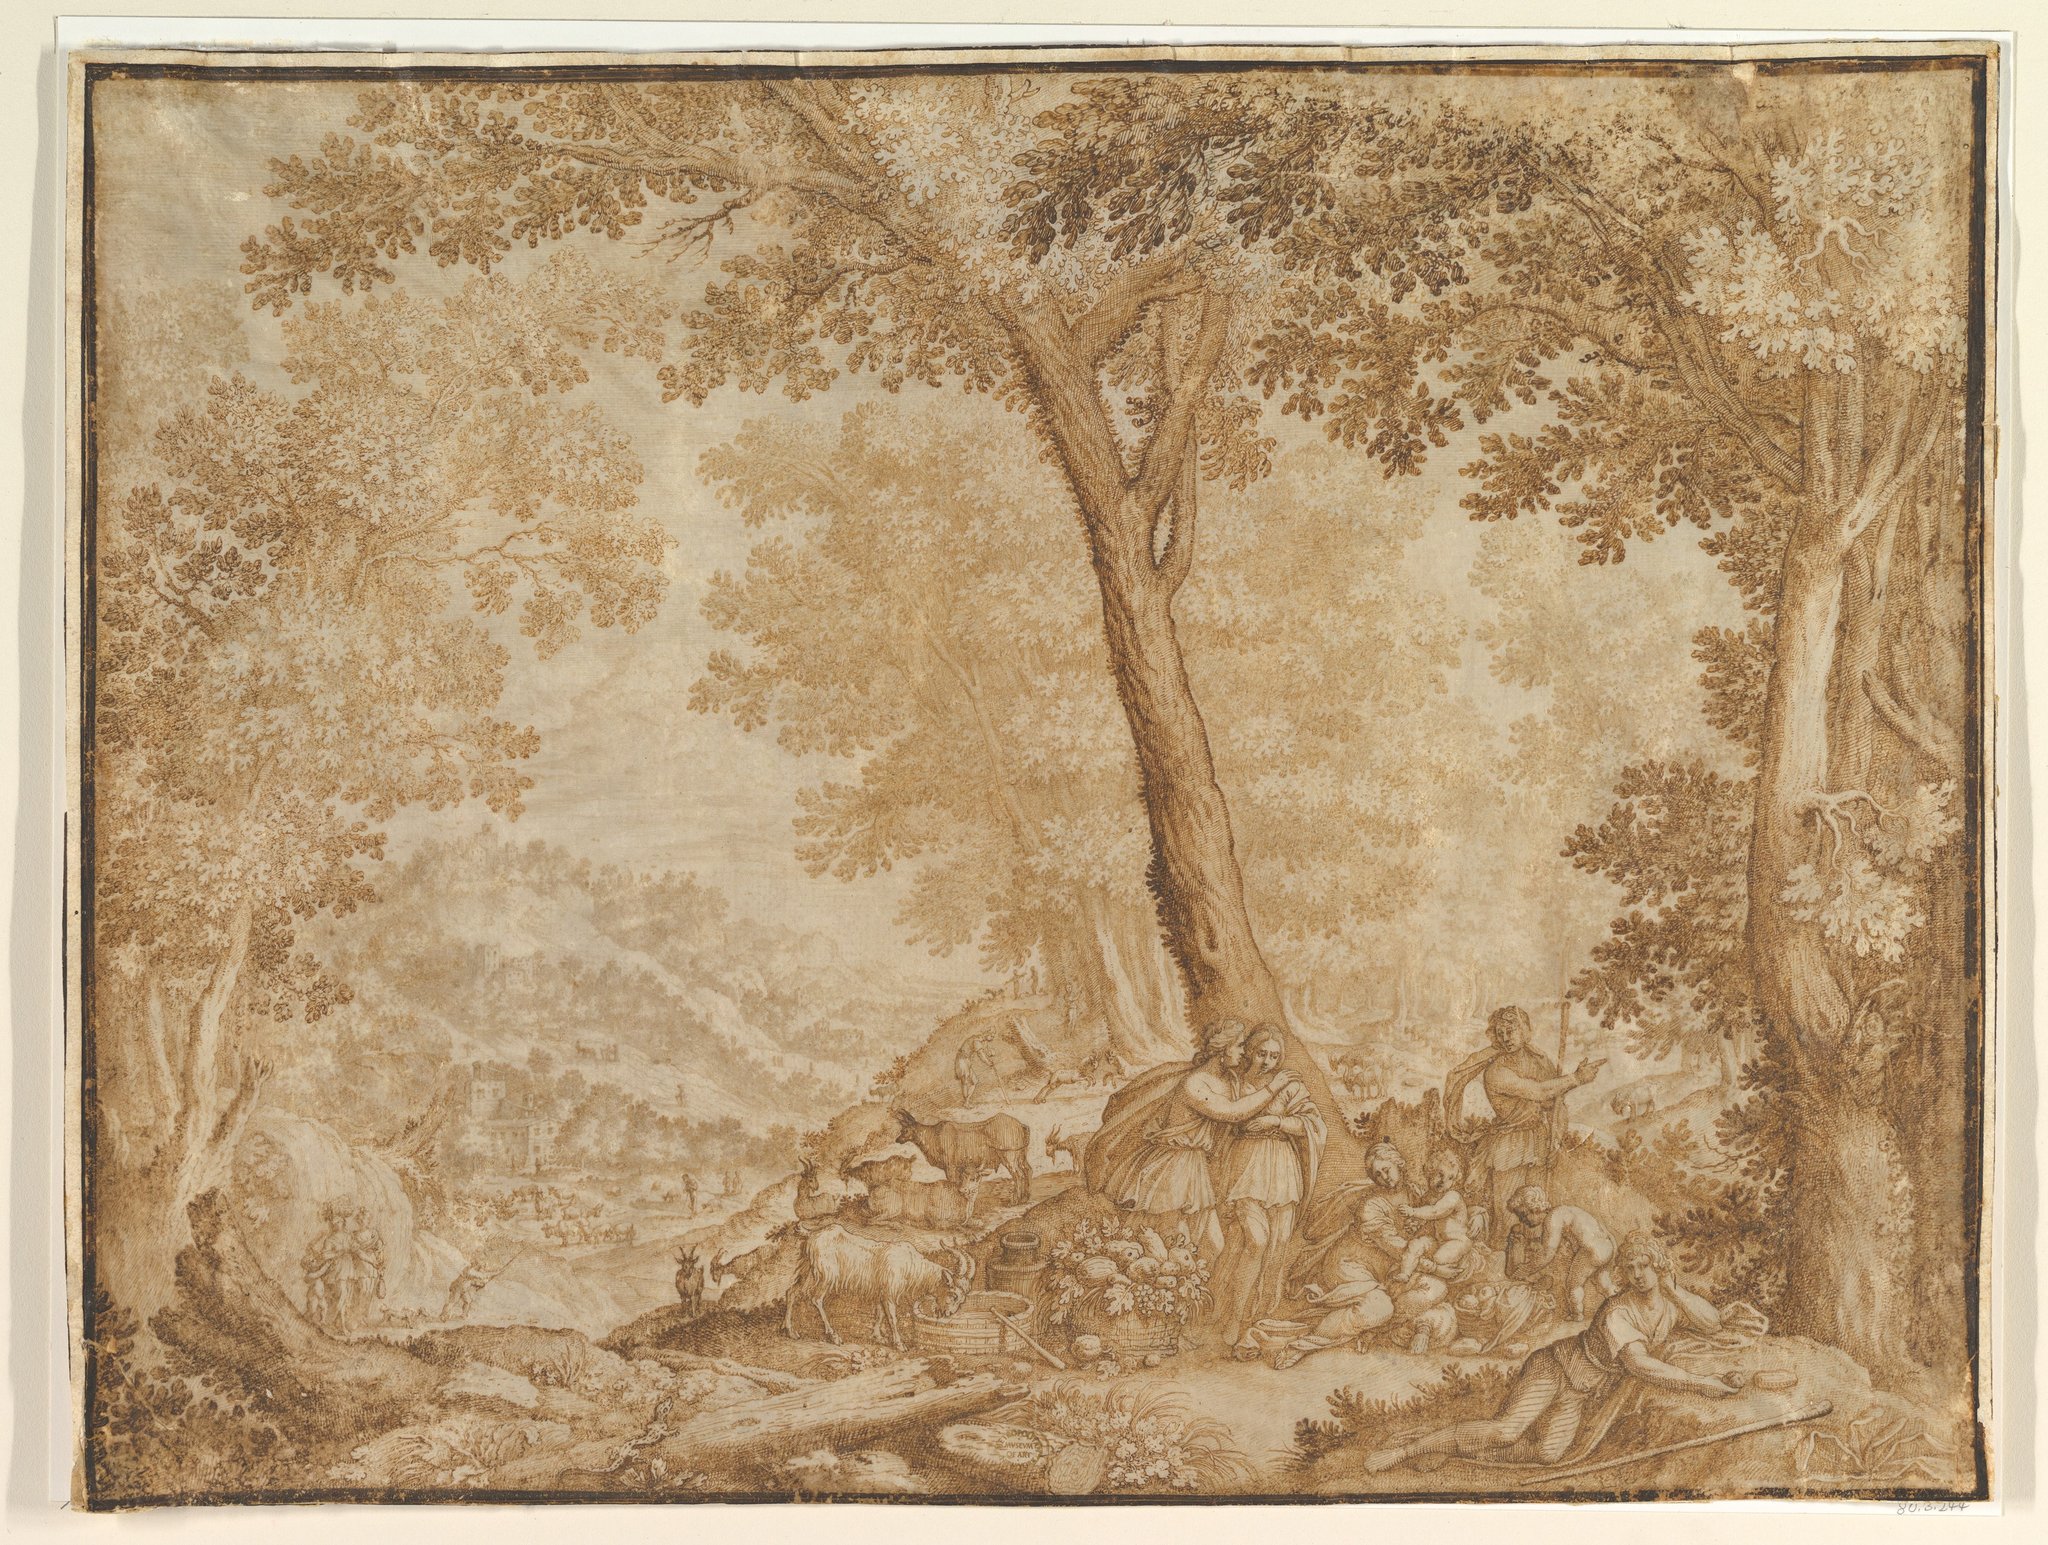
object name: drawing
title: Landscape with Figures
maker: anonymous, italian, 17th century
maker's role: artist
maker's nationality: italian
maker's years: 1600-1700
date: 1601-1700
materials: ink, parchment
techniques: drawing, engraving, pen, wash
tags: men,women,goats,landscapes,trees